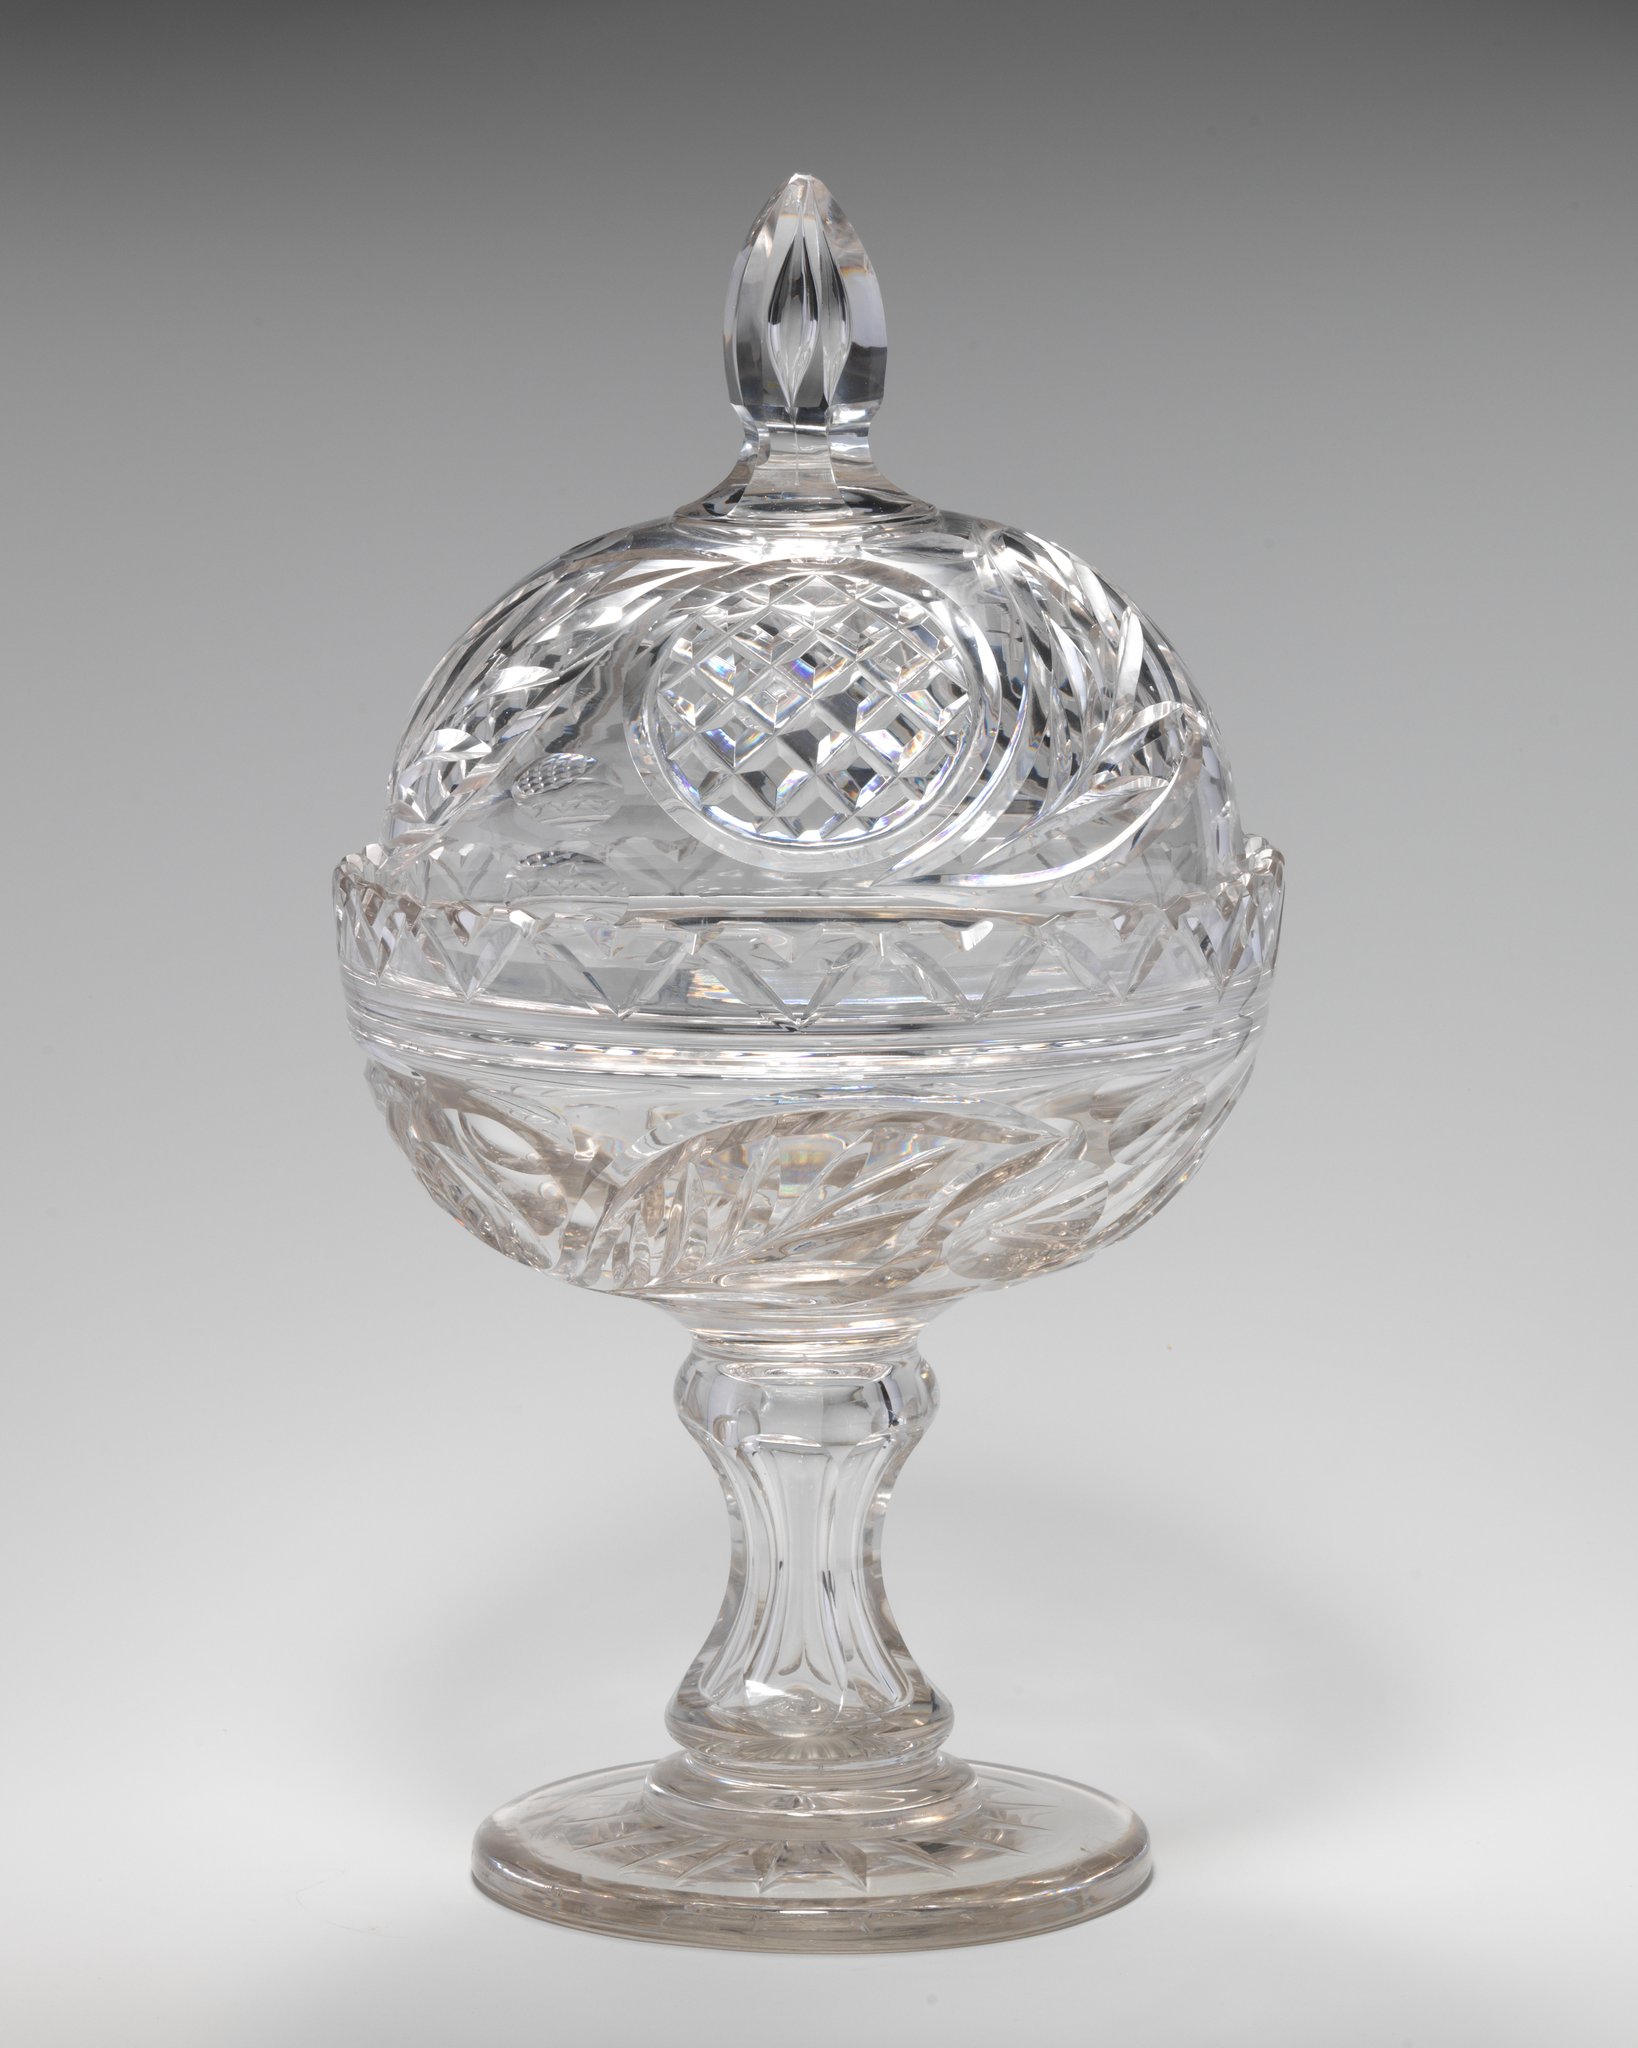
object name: sweetmeat glass with cover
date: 1801-1833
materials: glass